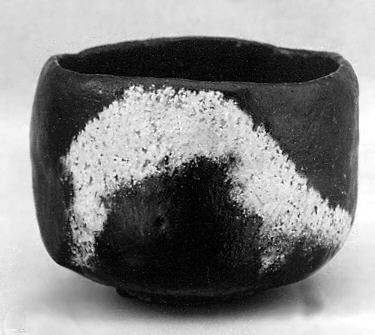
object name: teabowl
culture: japanese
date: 1701-1800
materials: clay, glaze